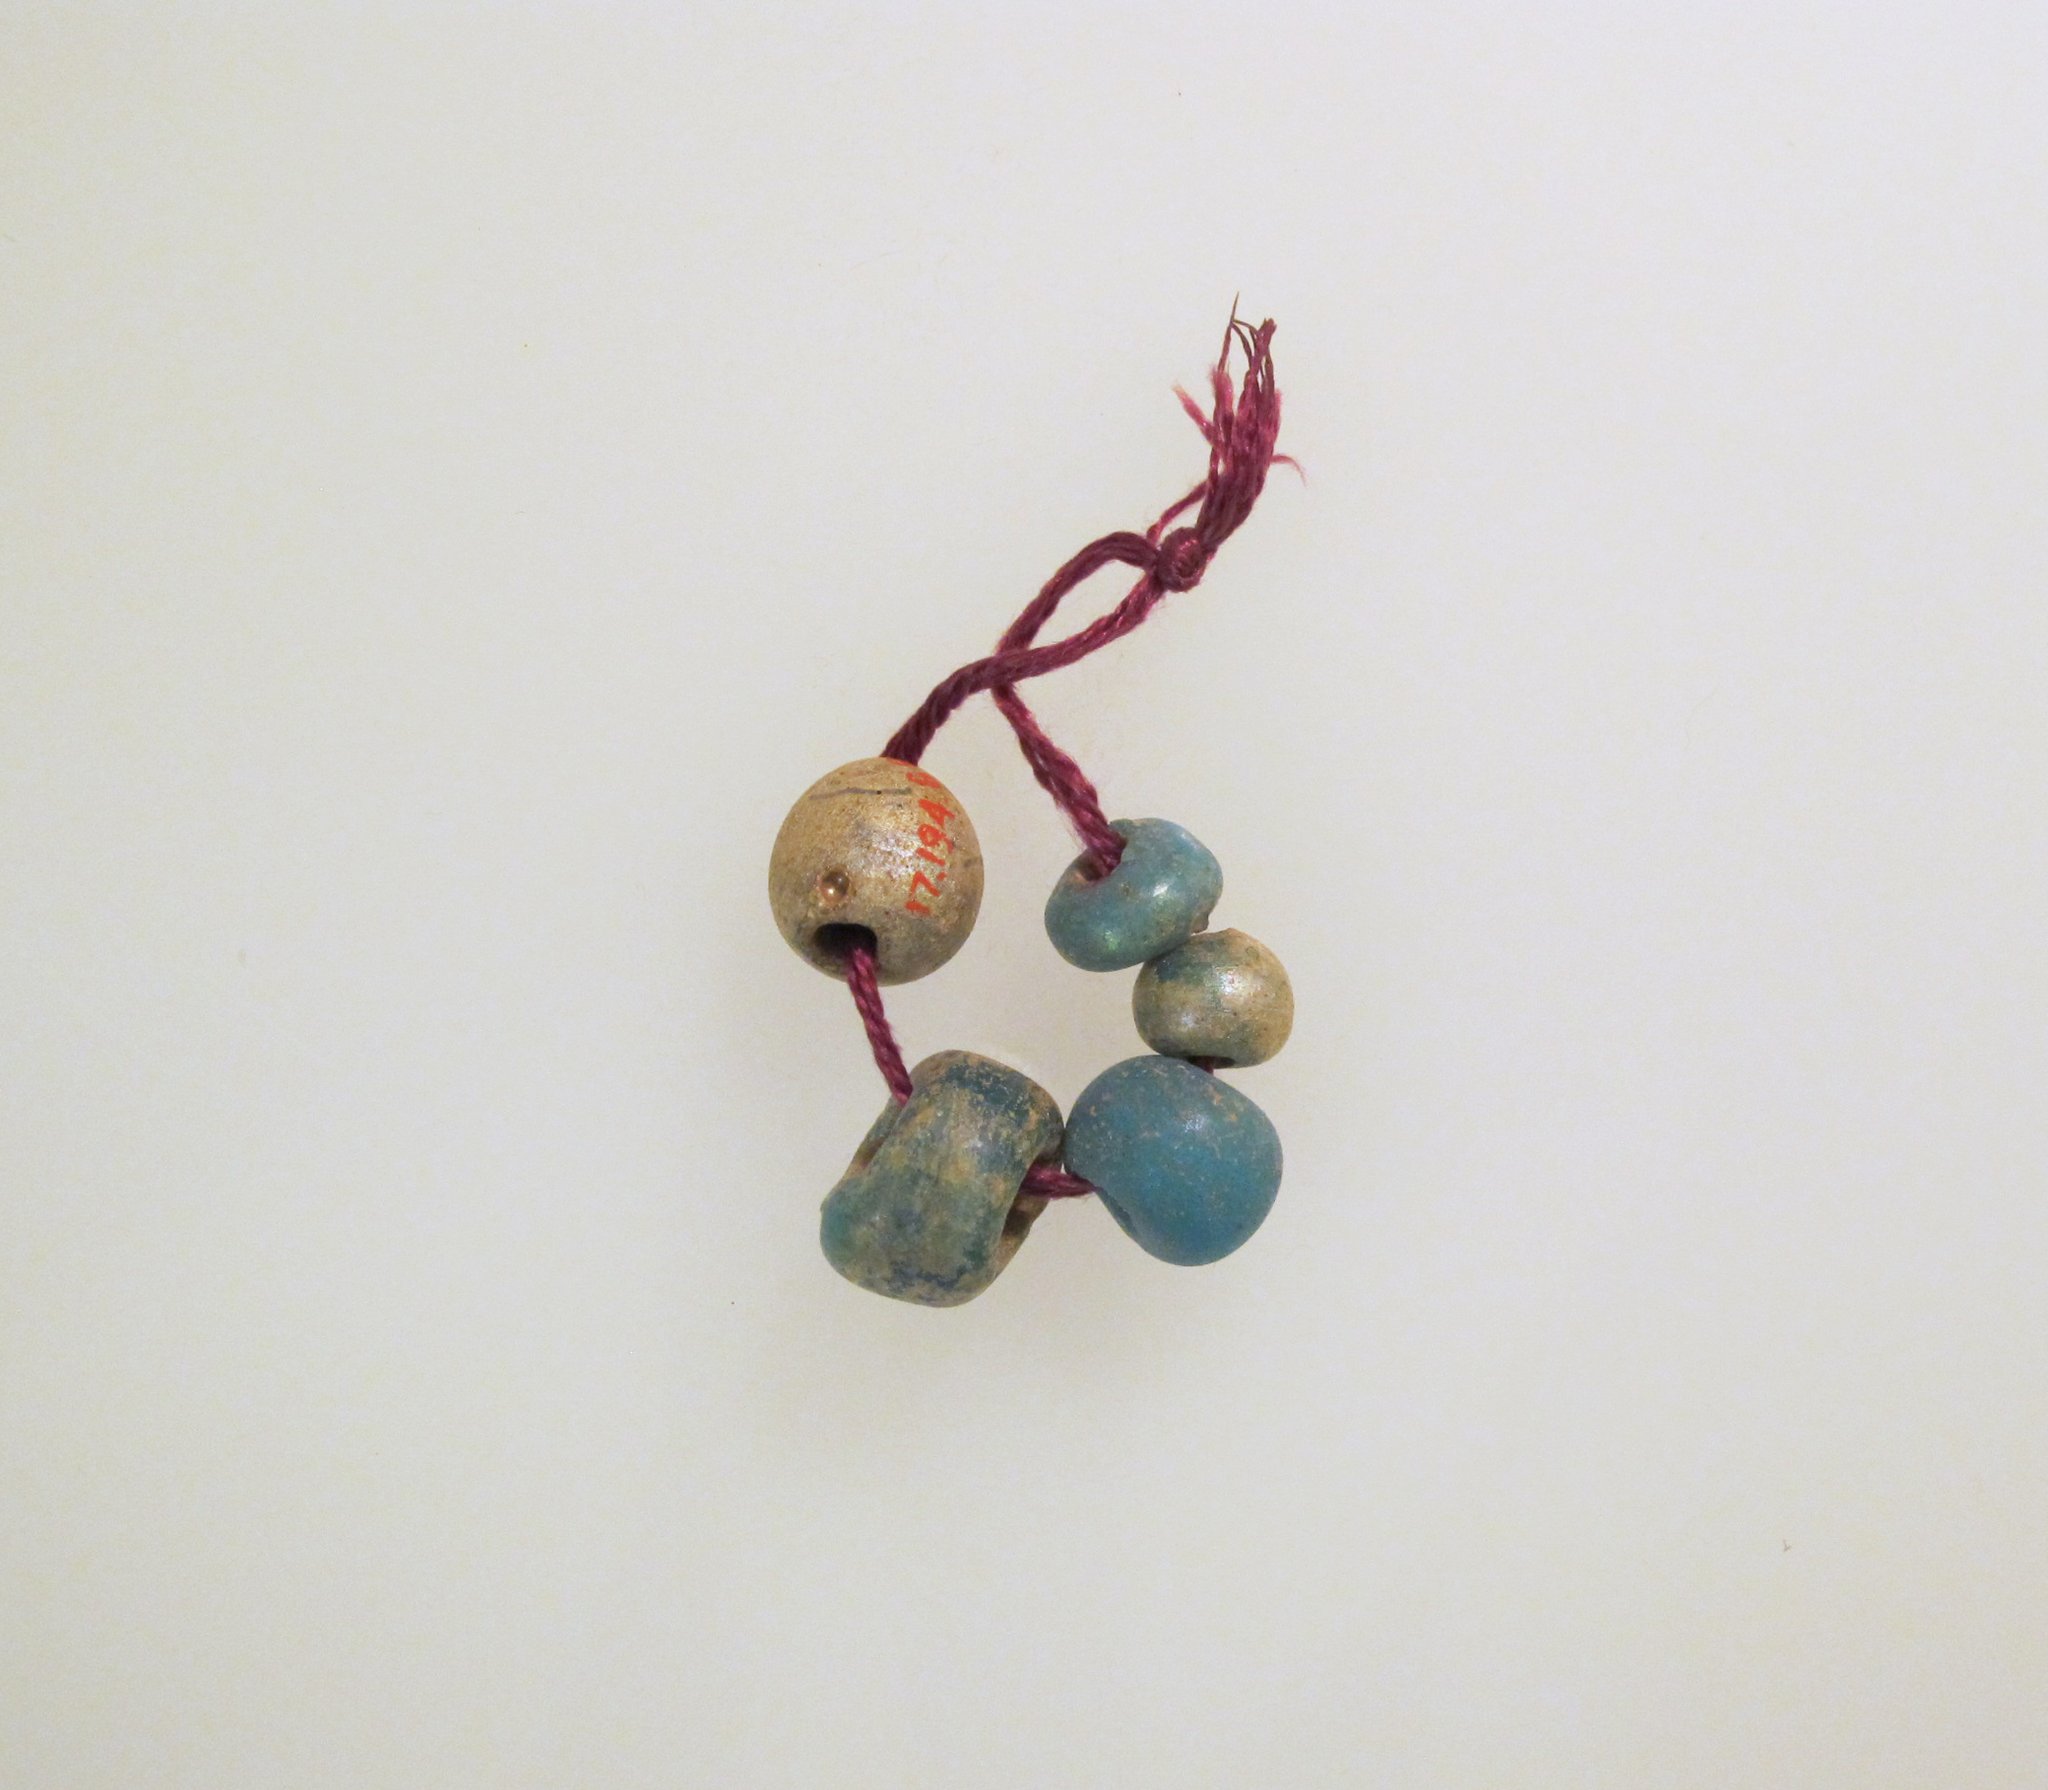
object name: bead, 5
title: Beads, 5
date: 7000 BCE-330 CE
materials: glass